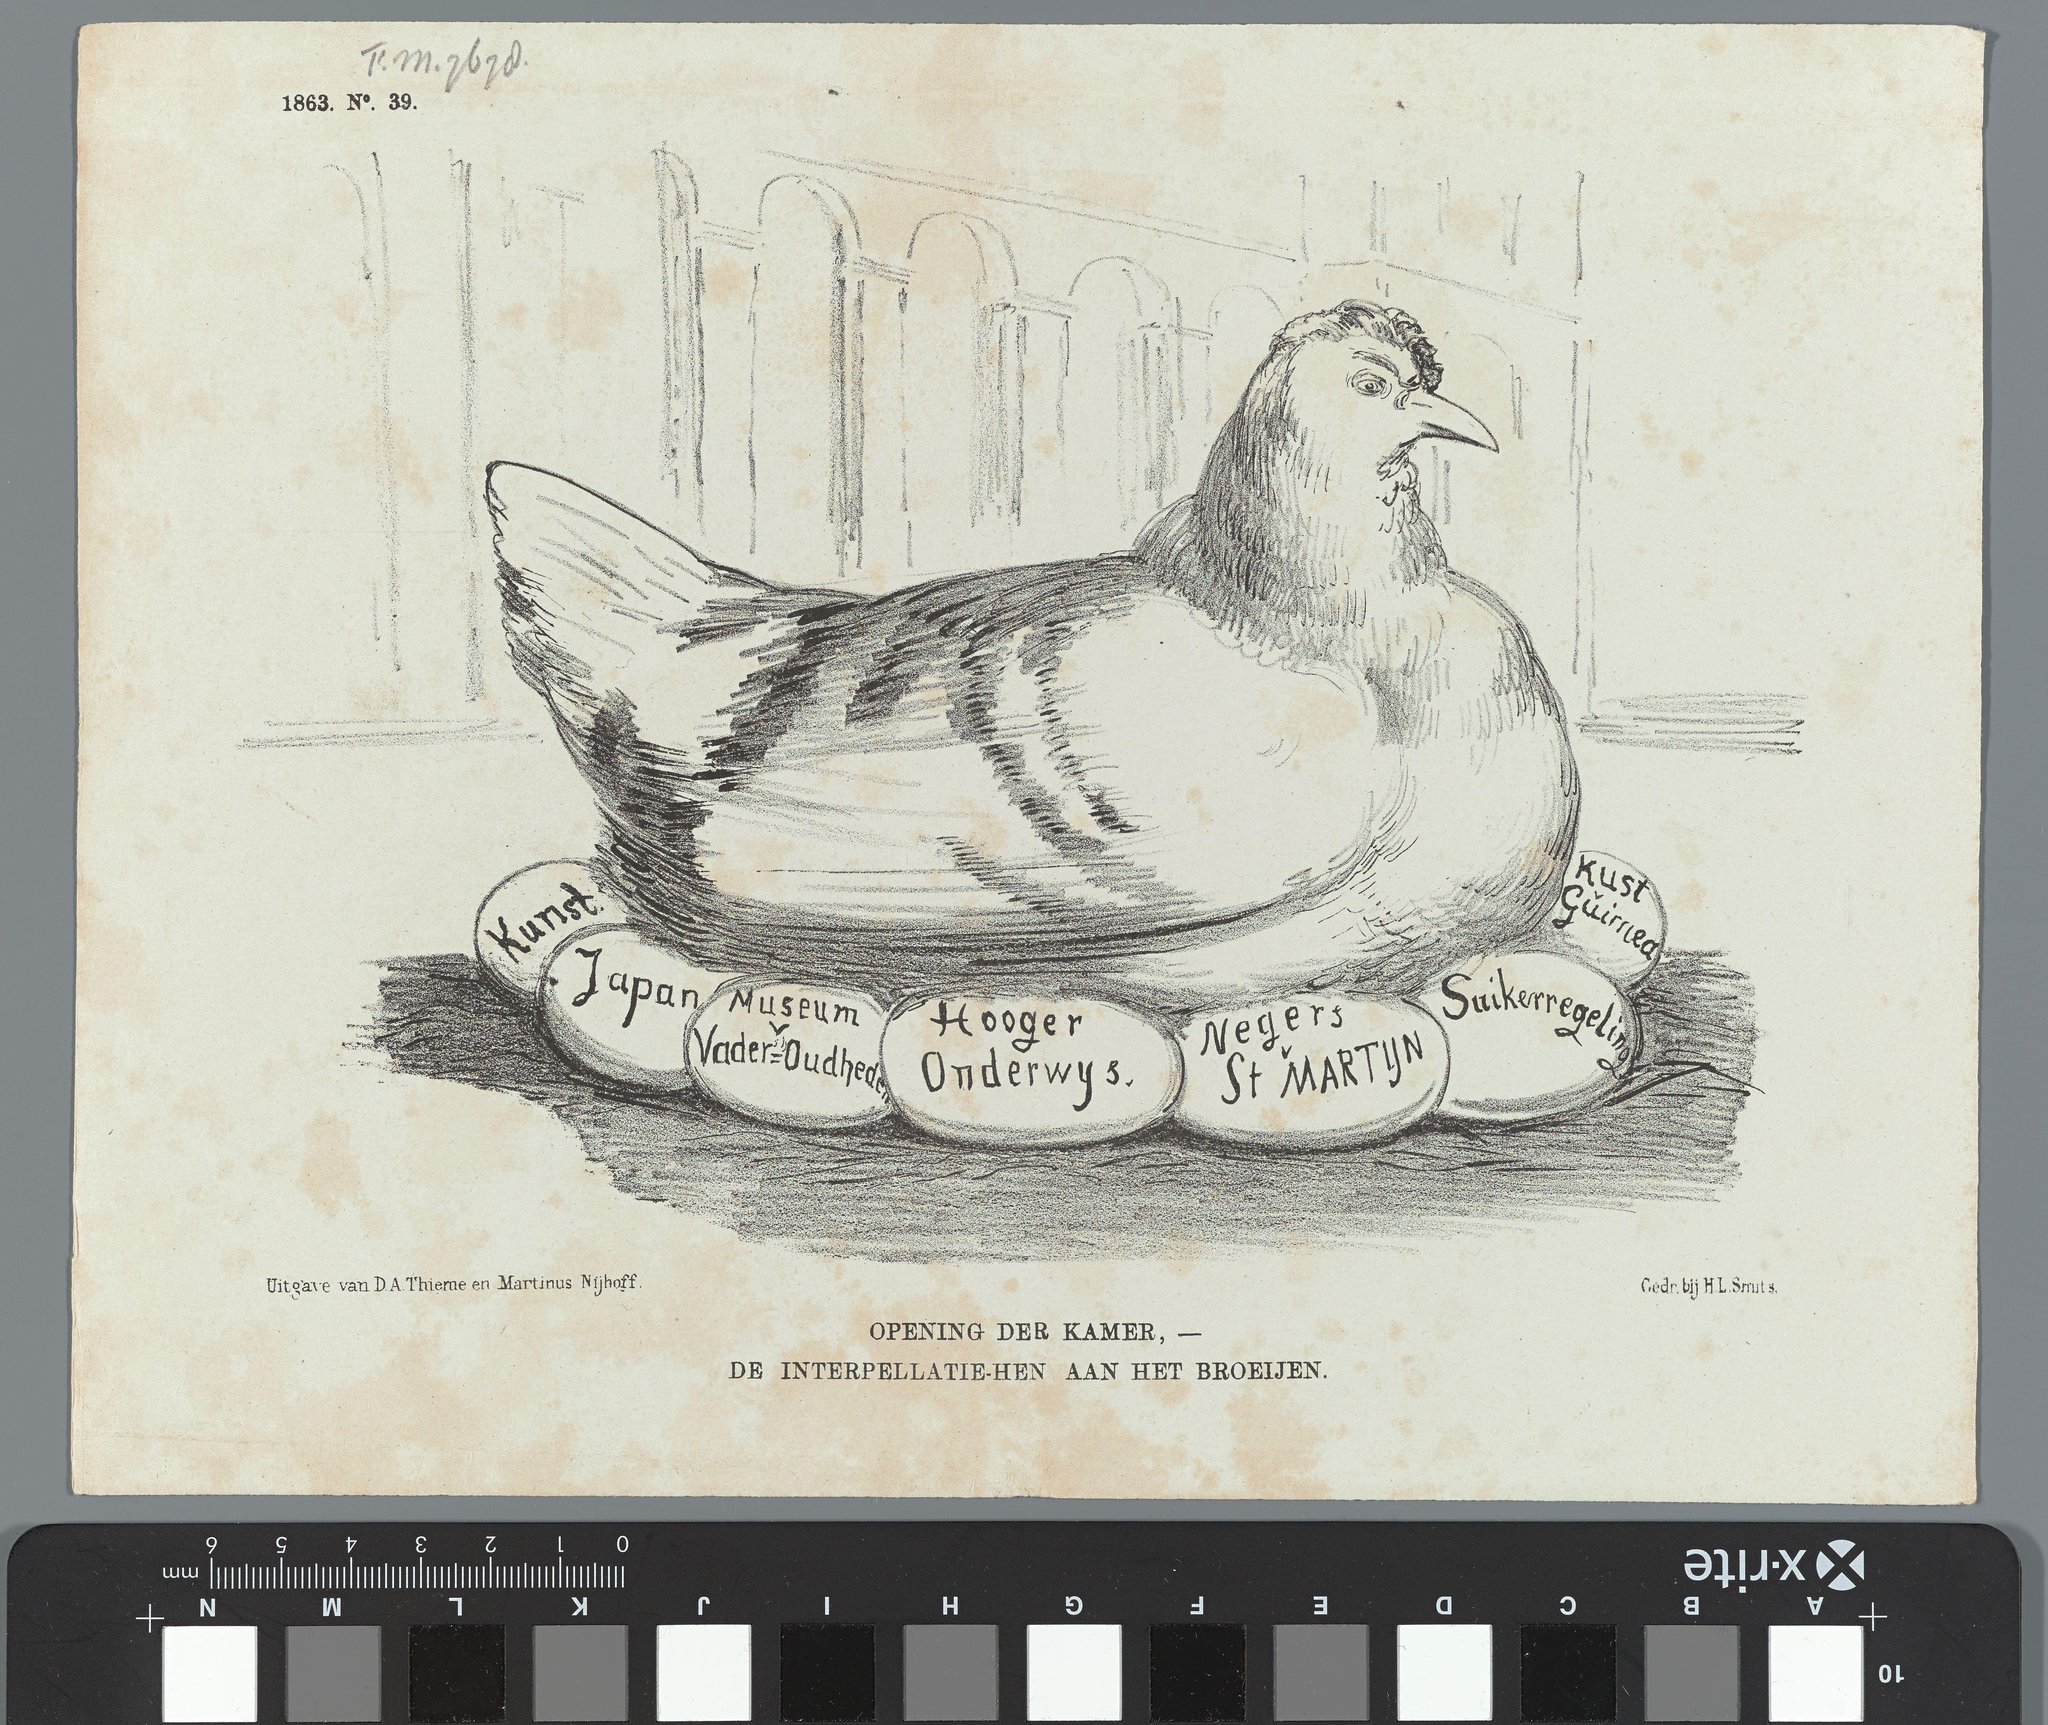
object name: cartoon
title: Spotprent op de talrijke interpellaties bij de opening van de Staten-Generaal, 1863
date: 1863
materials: paper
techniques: lithograph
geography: the hague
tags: fowl (cock, hen, chicken, etc.), eggs, egg-dishes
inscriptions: collector's mark: Lugt 2228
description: Spotprent op de talrijke interpellaties aangekondigt bij de opening van de Staten-Generaal. Een hen broedend op een nest met eieren. Plaat verschenen bij het weekblad De Nederlandsche Spectator, nr. 39, 26 september 1863.